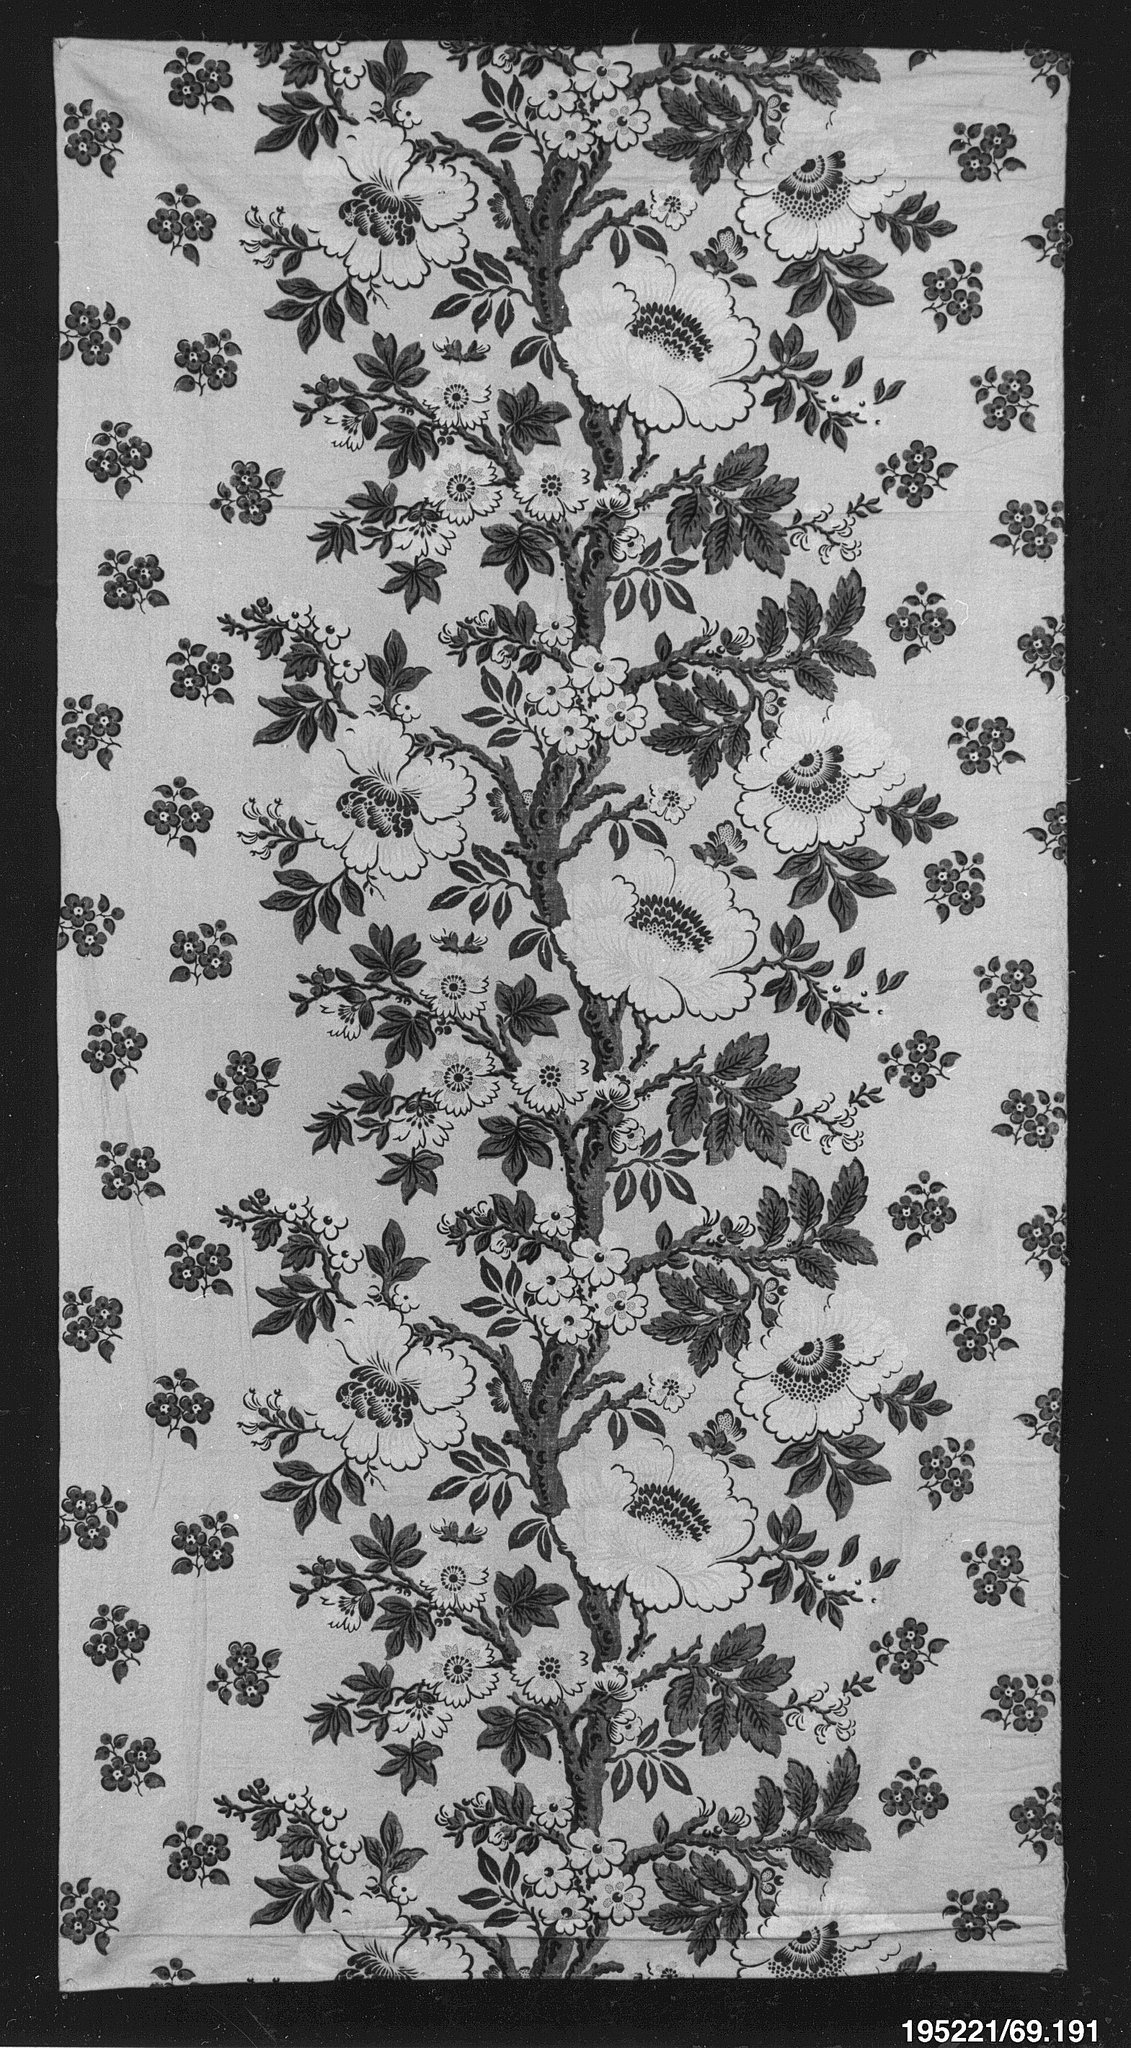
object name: length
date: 1830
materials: cotton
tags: flowers